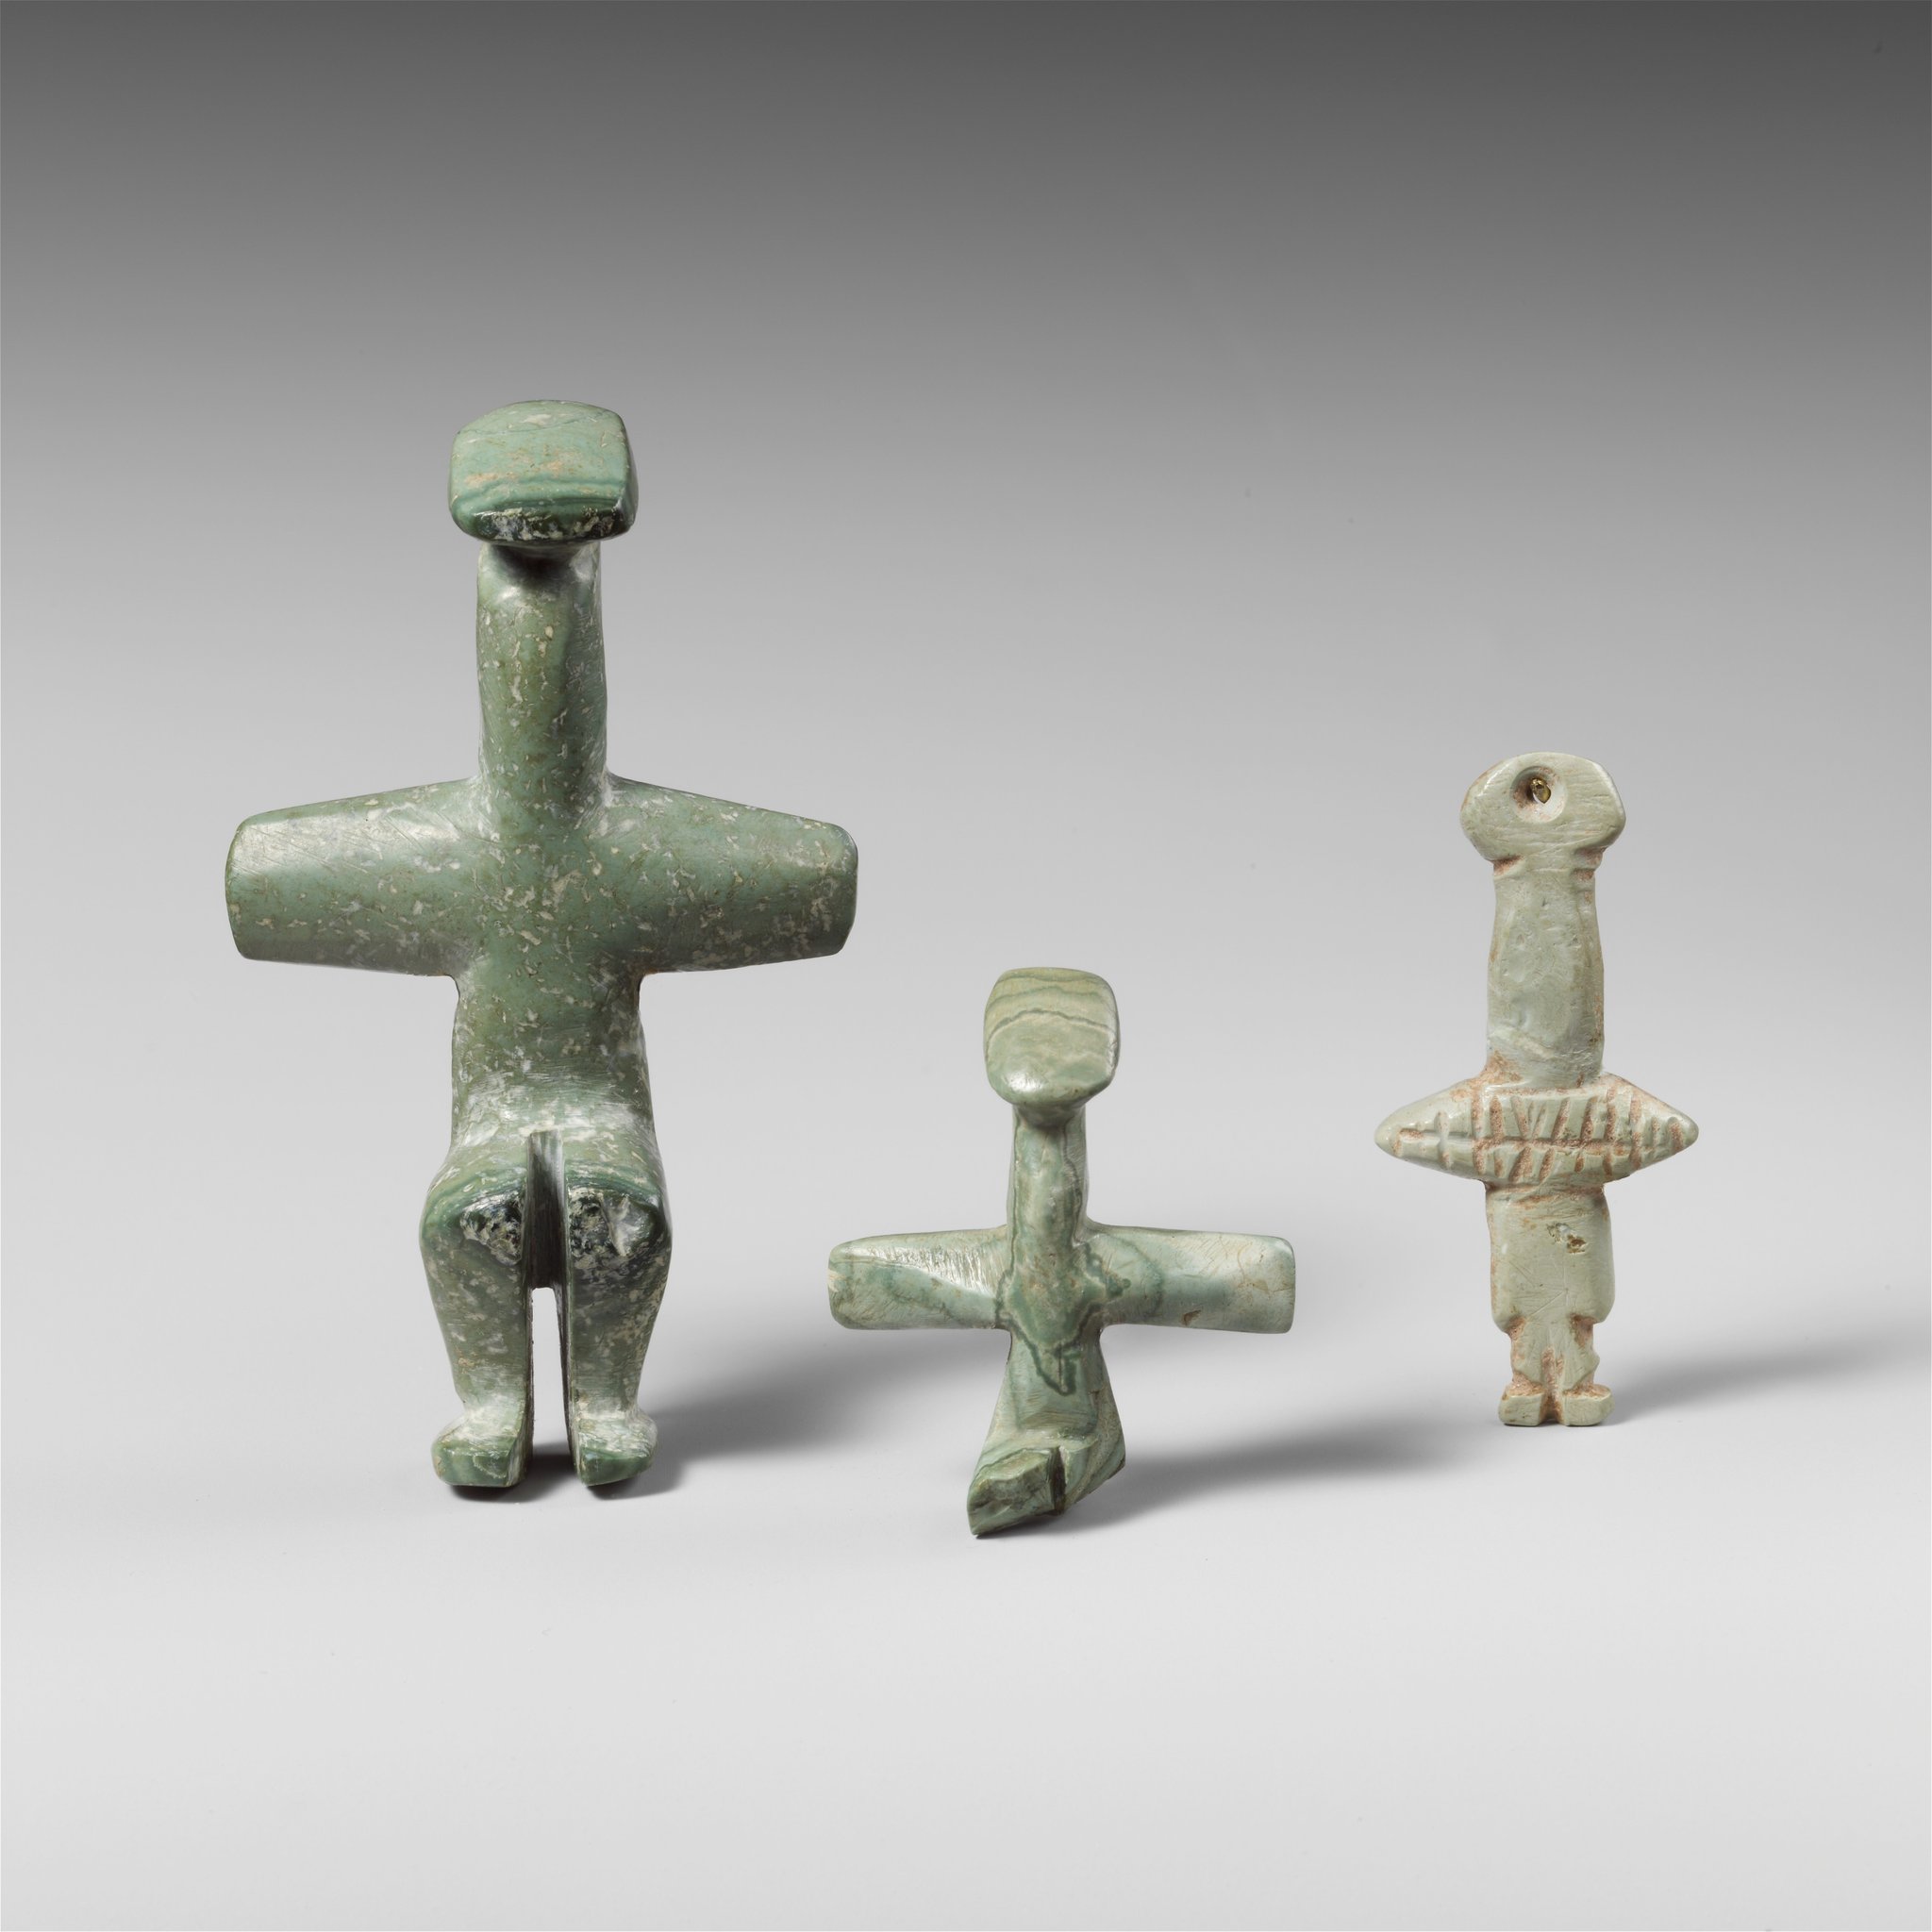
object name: figure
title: Picrolite figure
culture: cypriot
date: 3900-2500 BCE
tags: human figures